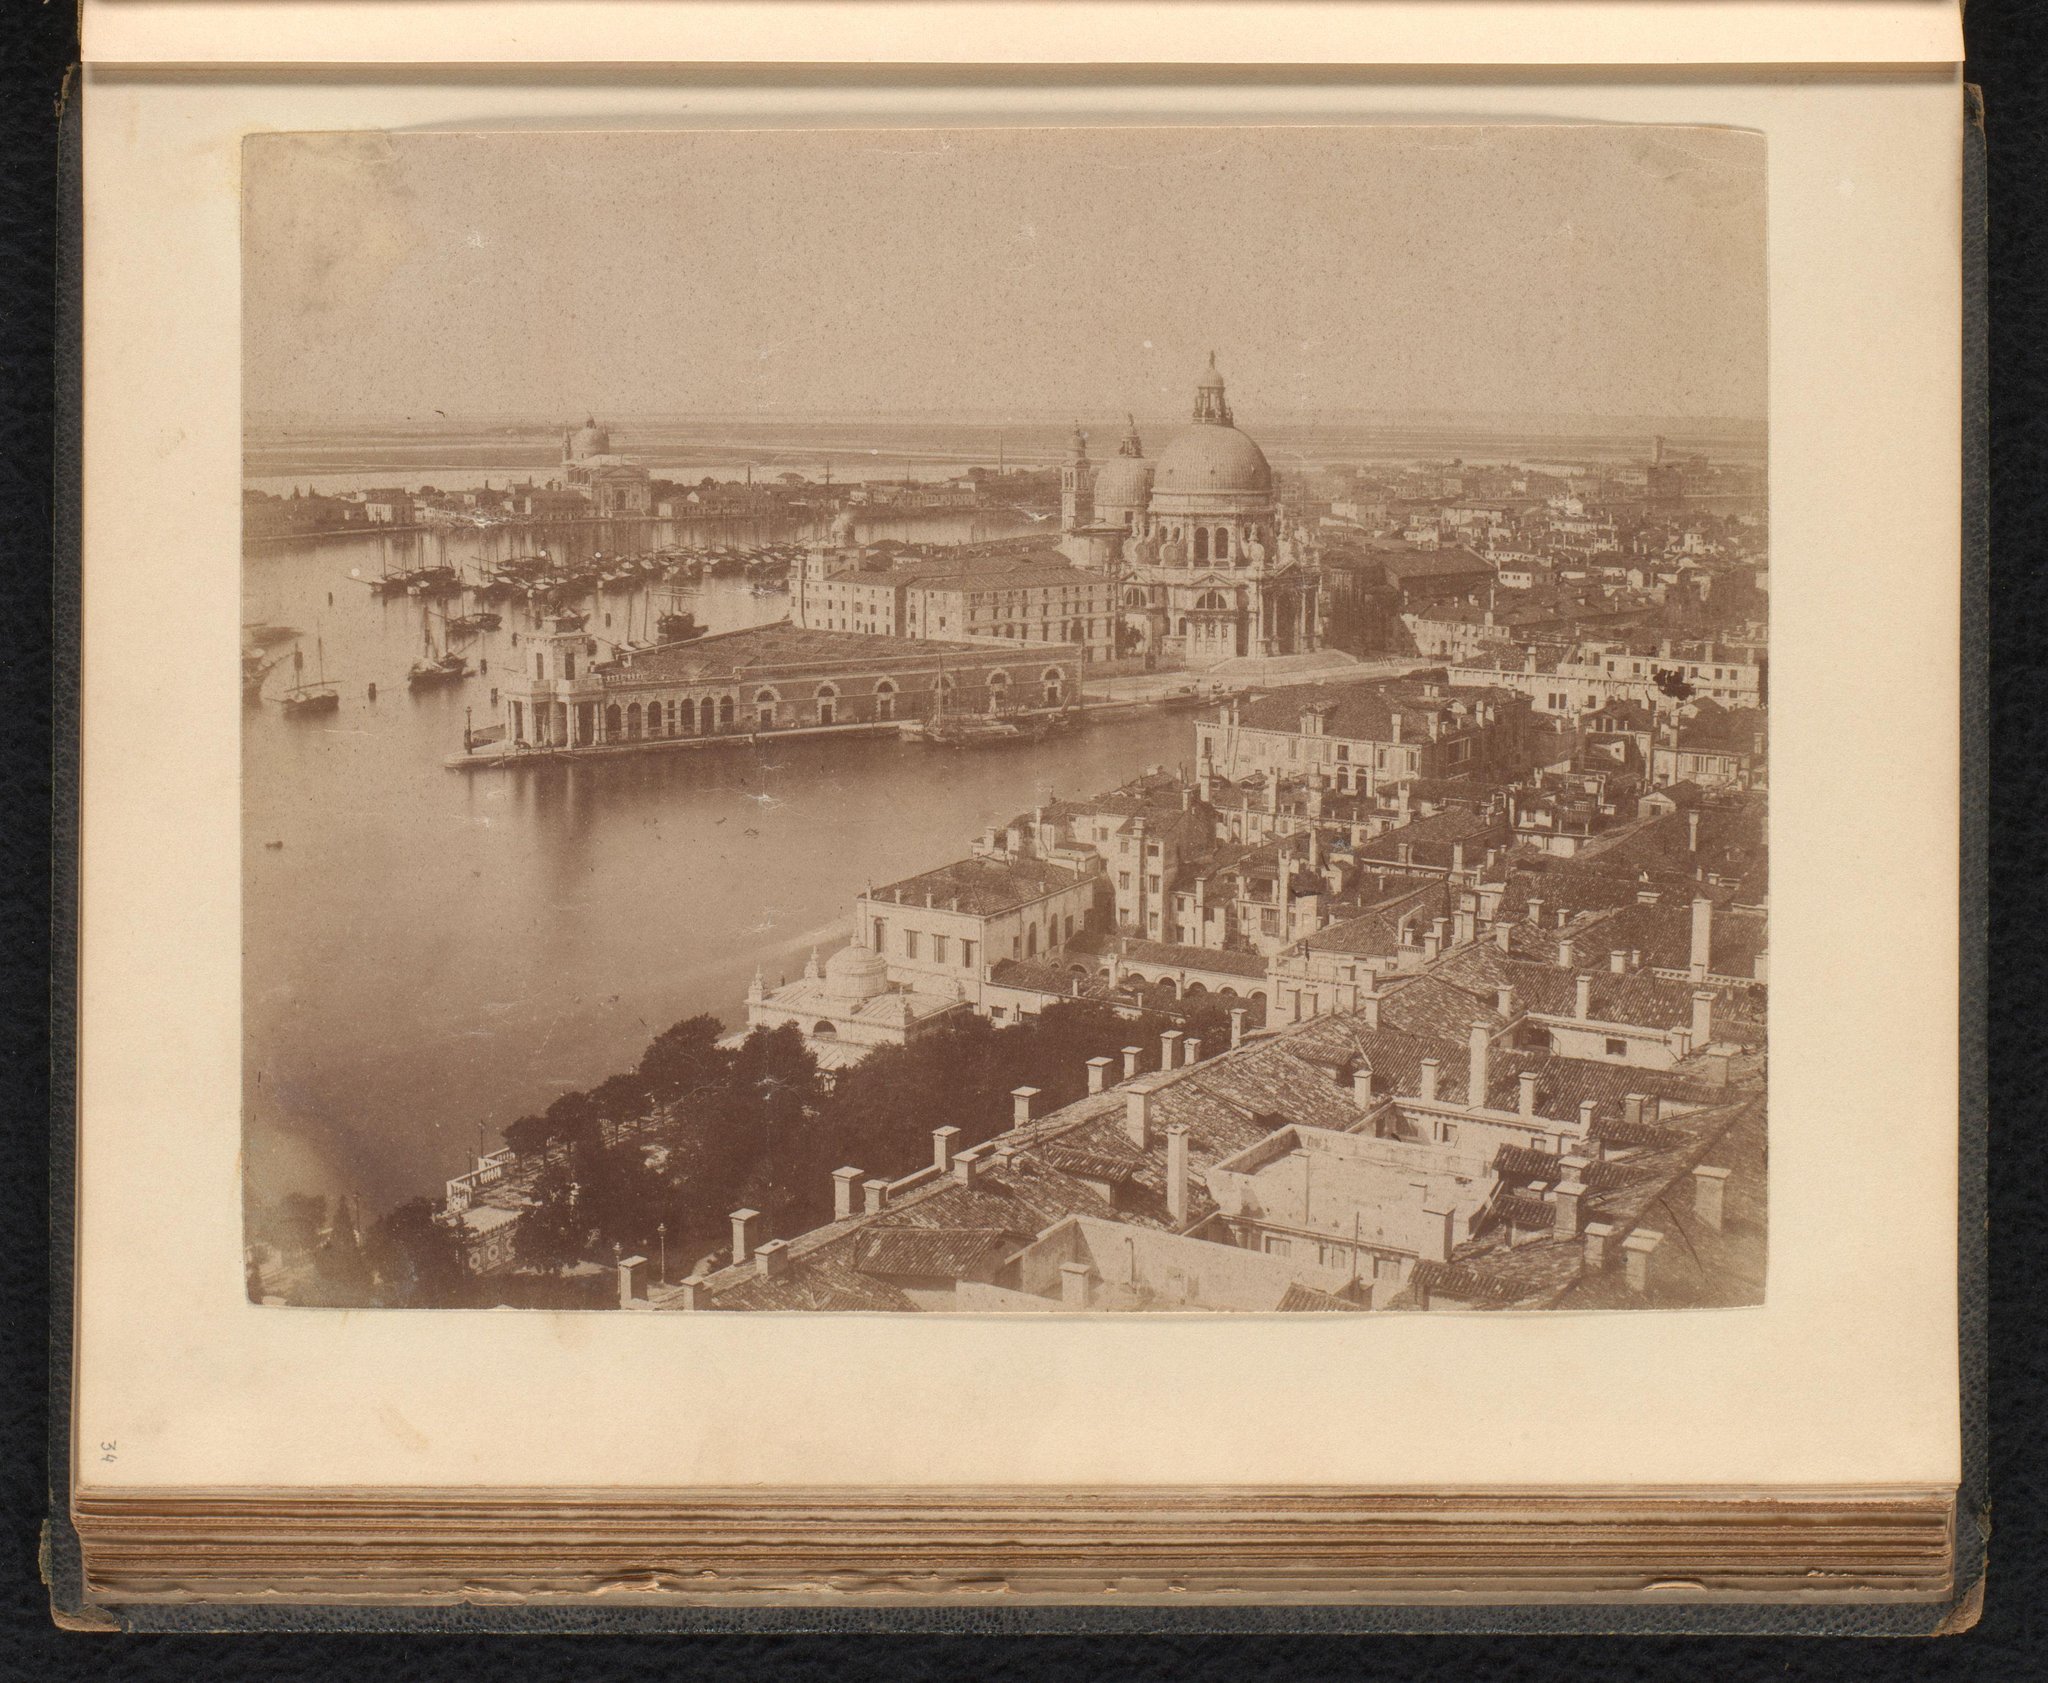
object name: photograph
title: Gezicht op de Punta della Dogana en de Basilica di Santa Maria della Salute in Venetië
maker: Anonymous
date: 1855-1870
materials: paper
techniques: albumen print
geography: venice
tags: city-view in general; 'veduta', church (exterior), canals, waters (in city)